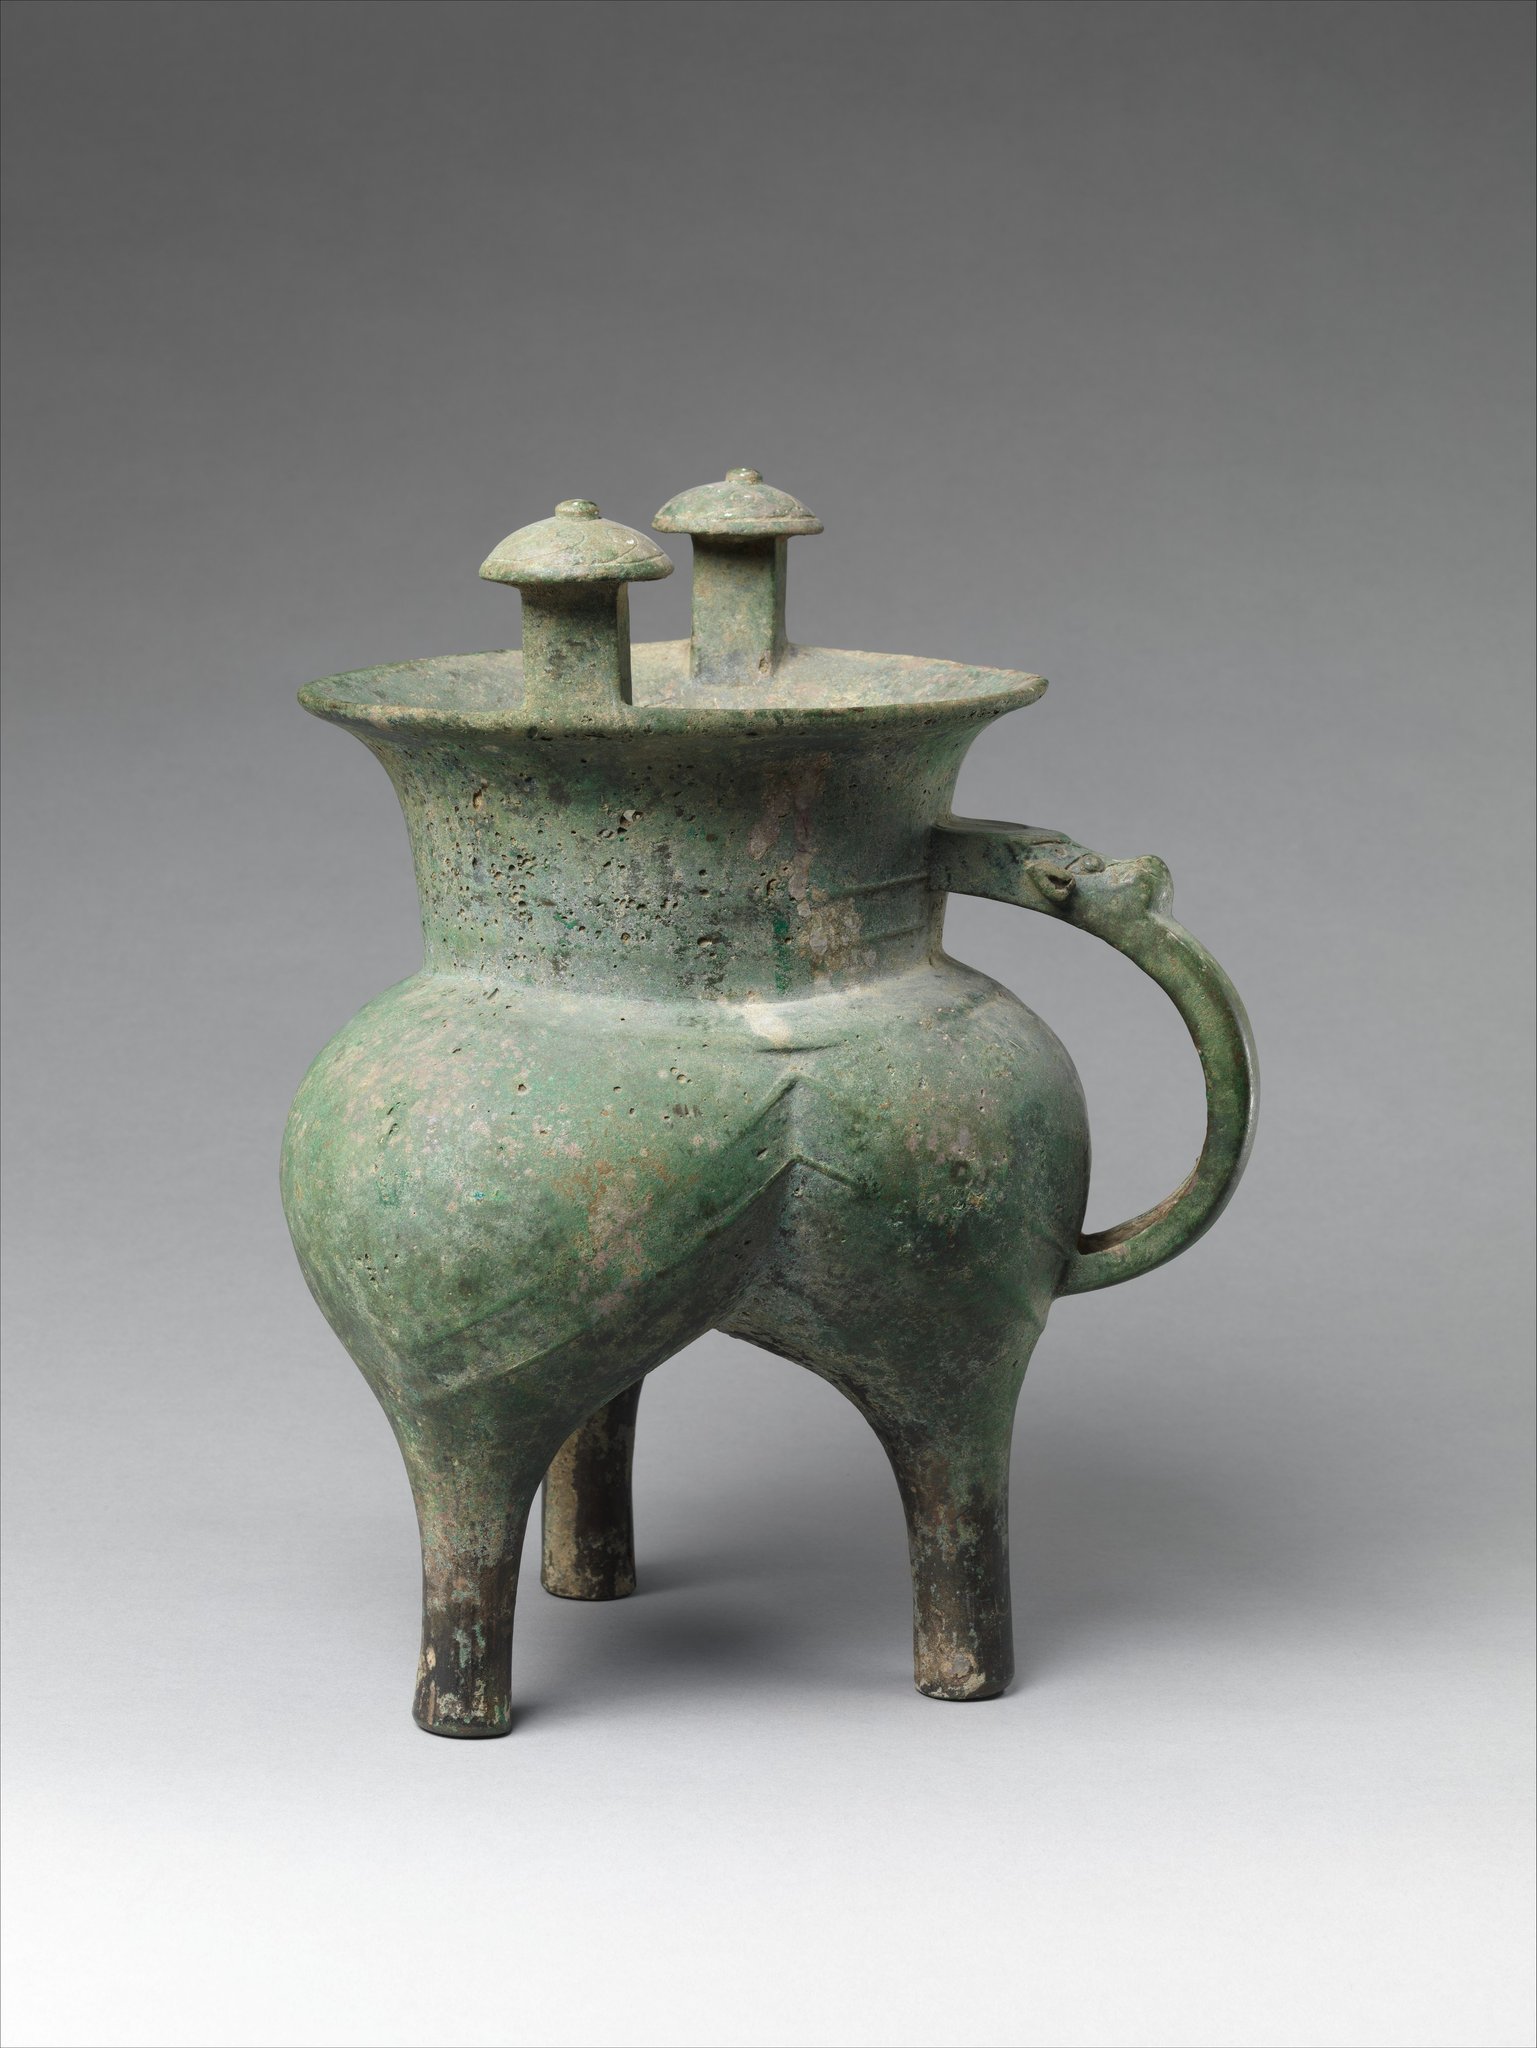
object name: wine container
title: Ritual Wine Container (Jia)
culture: chinese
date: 1034-1001 BCE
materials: bronze